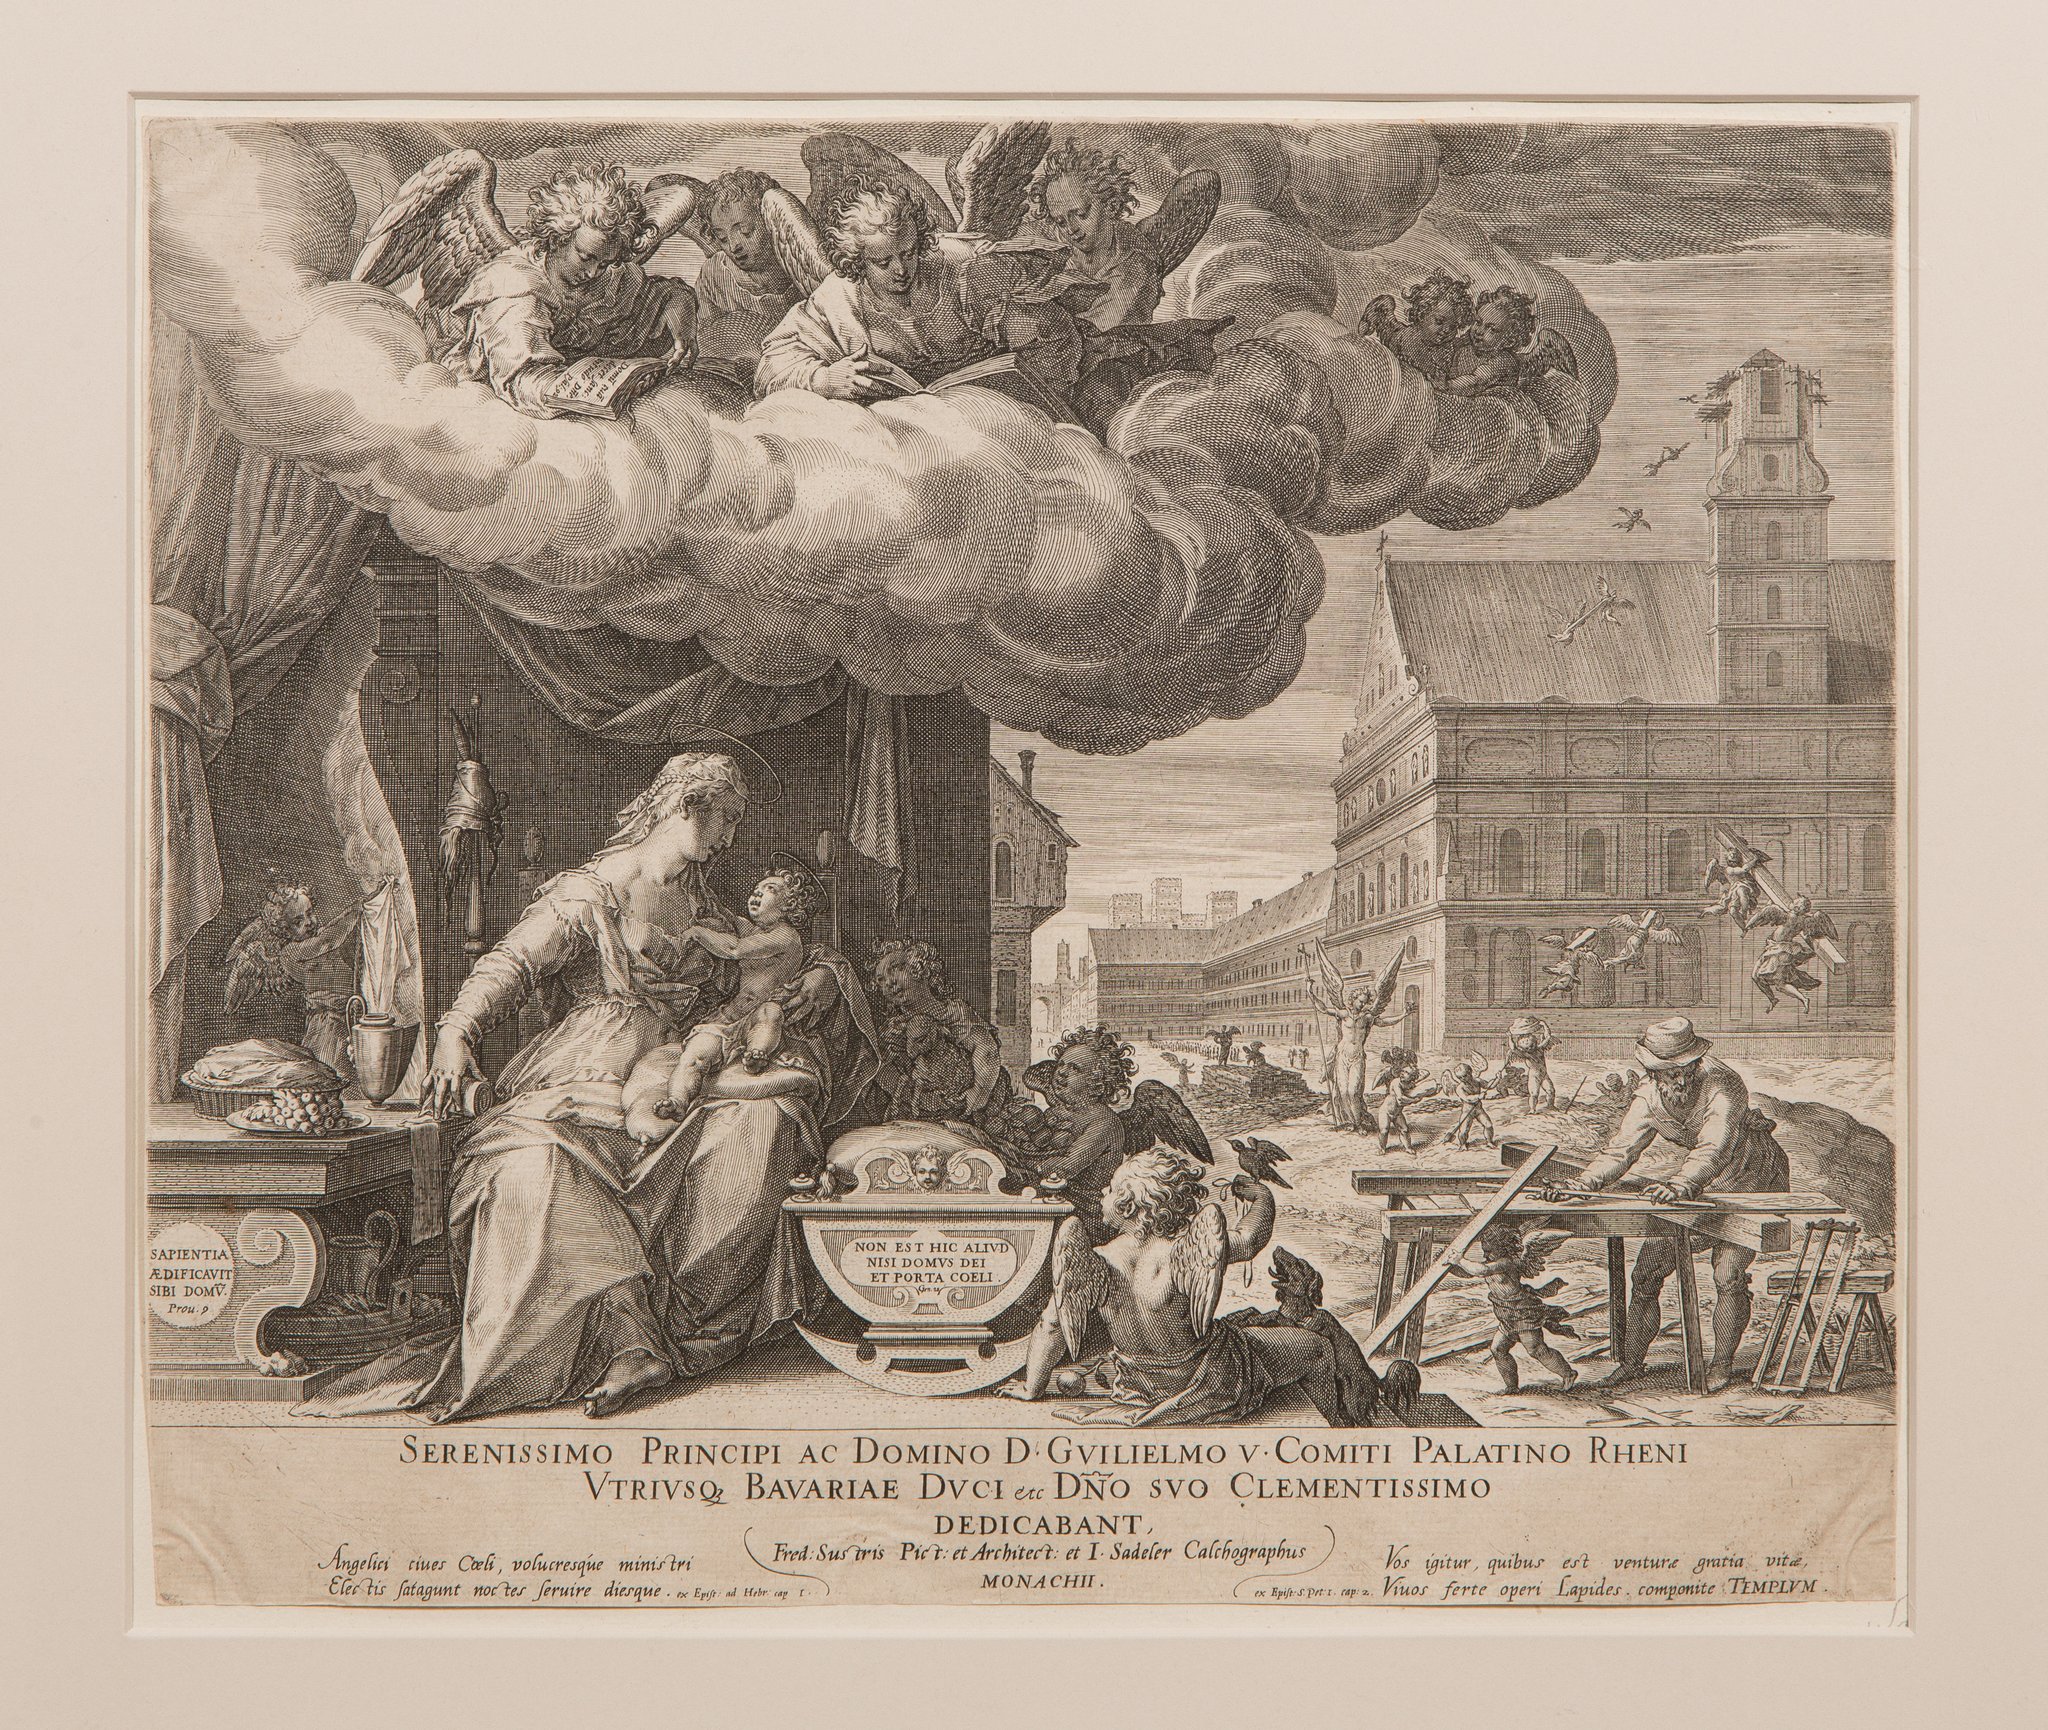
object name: print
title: The Holy Family with the Church of Saint Michael in Munich under Construction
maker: johann sadeler (i)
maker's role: artist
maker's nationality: netherlandish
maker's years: 1550-1601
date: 1589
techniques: engraving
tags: angels,holy family,saint michael,virgin mary,jesus